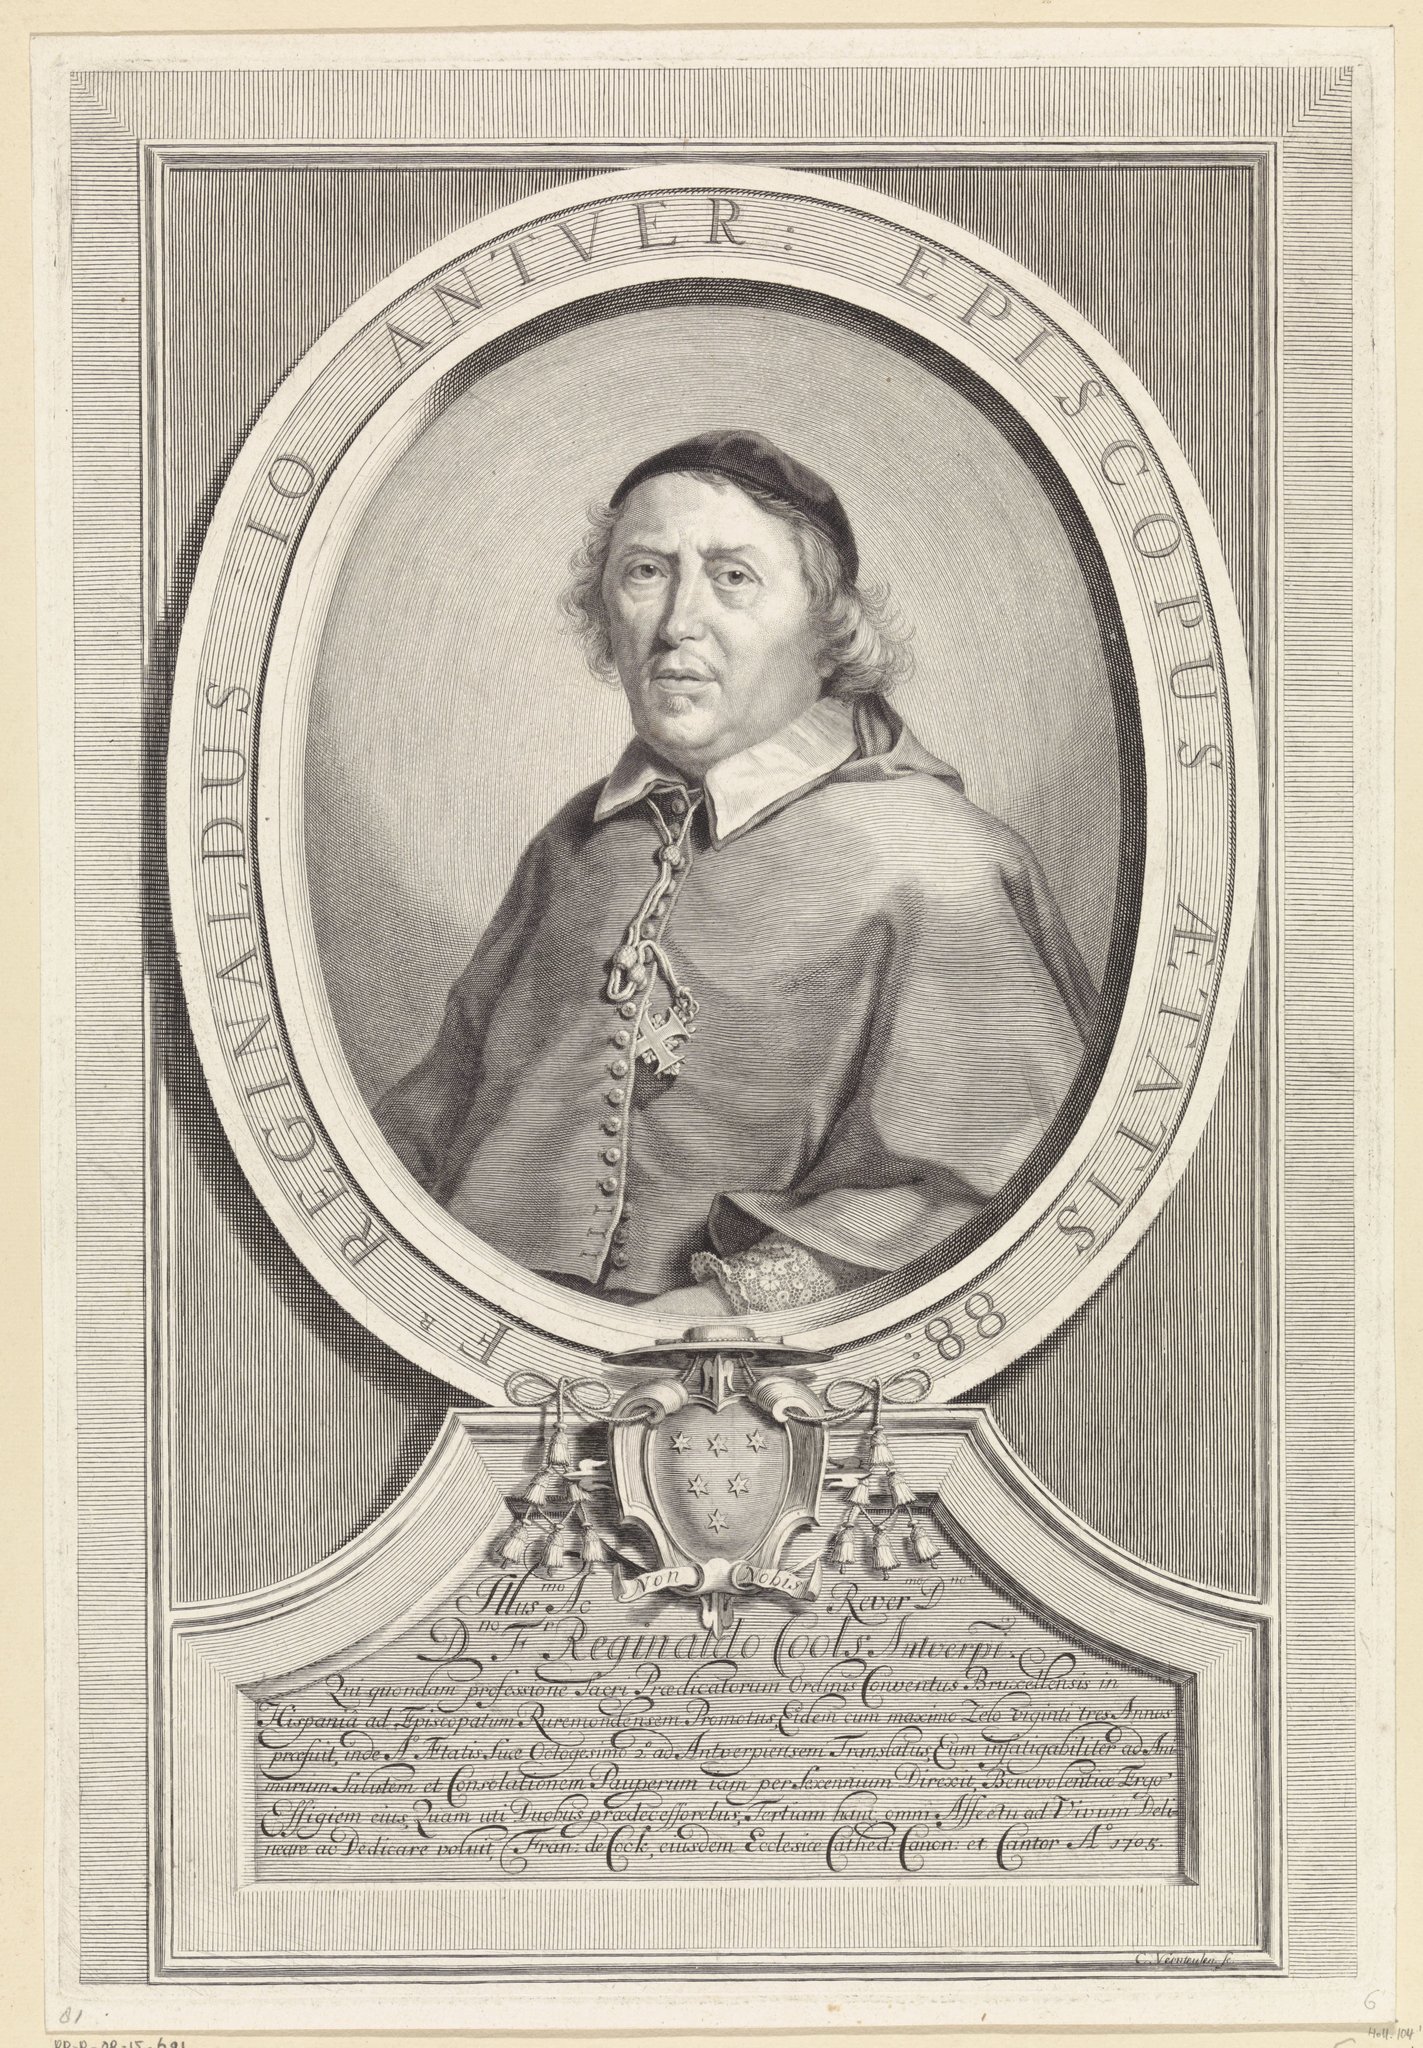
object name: print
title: Portret van Reginaldus Cools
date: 1705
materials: paper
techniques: engraving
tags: antwerp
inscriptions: collector's mark: Lugt 240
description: Portret van de bisschop Reginaldus Cools, op 88-jarige leeftijd.